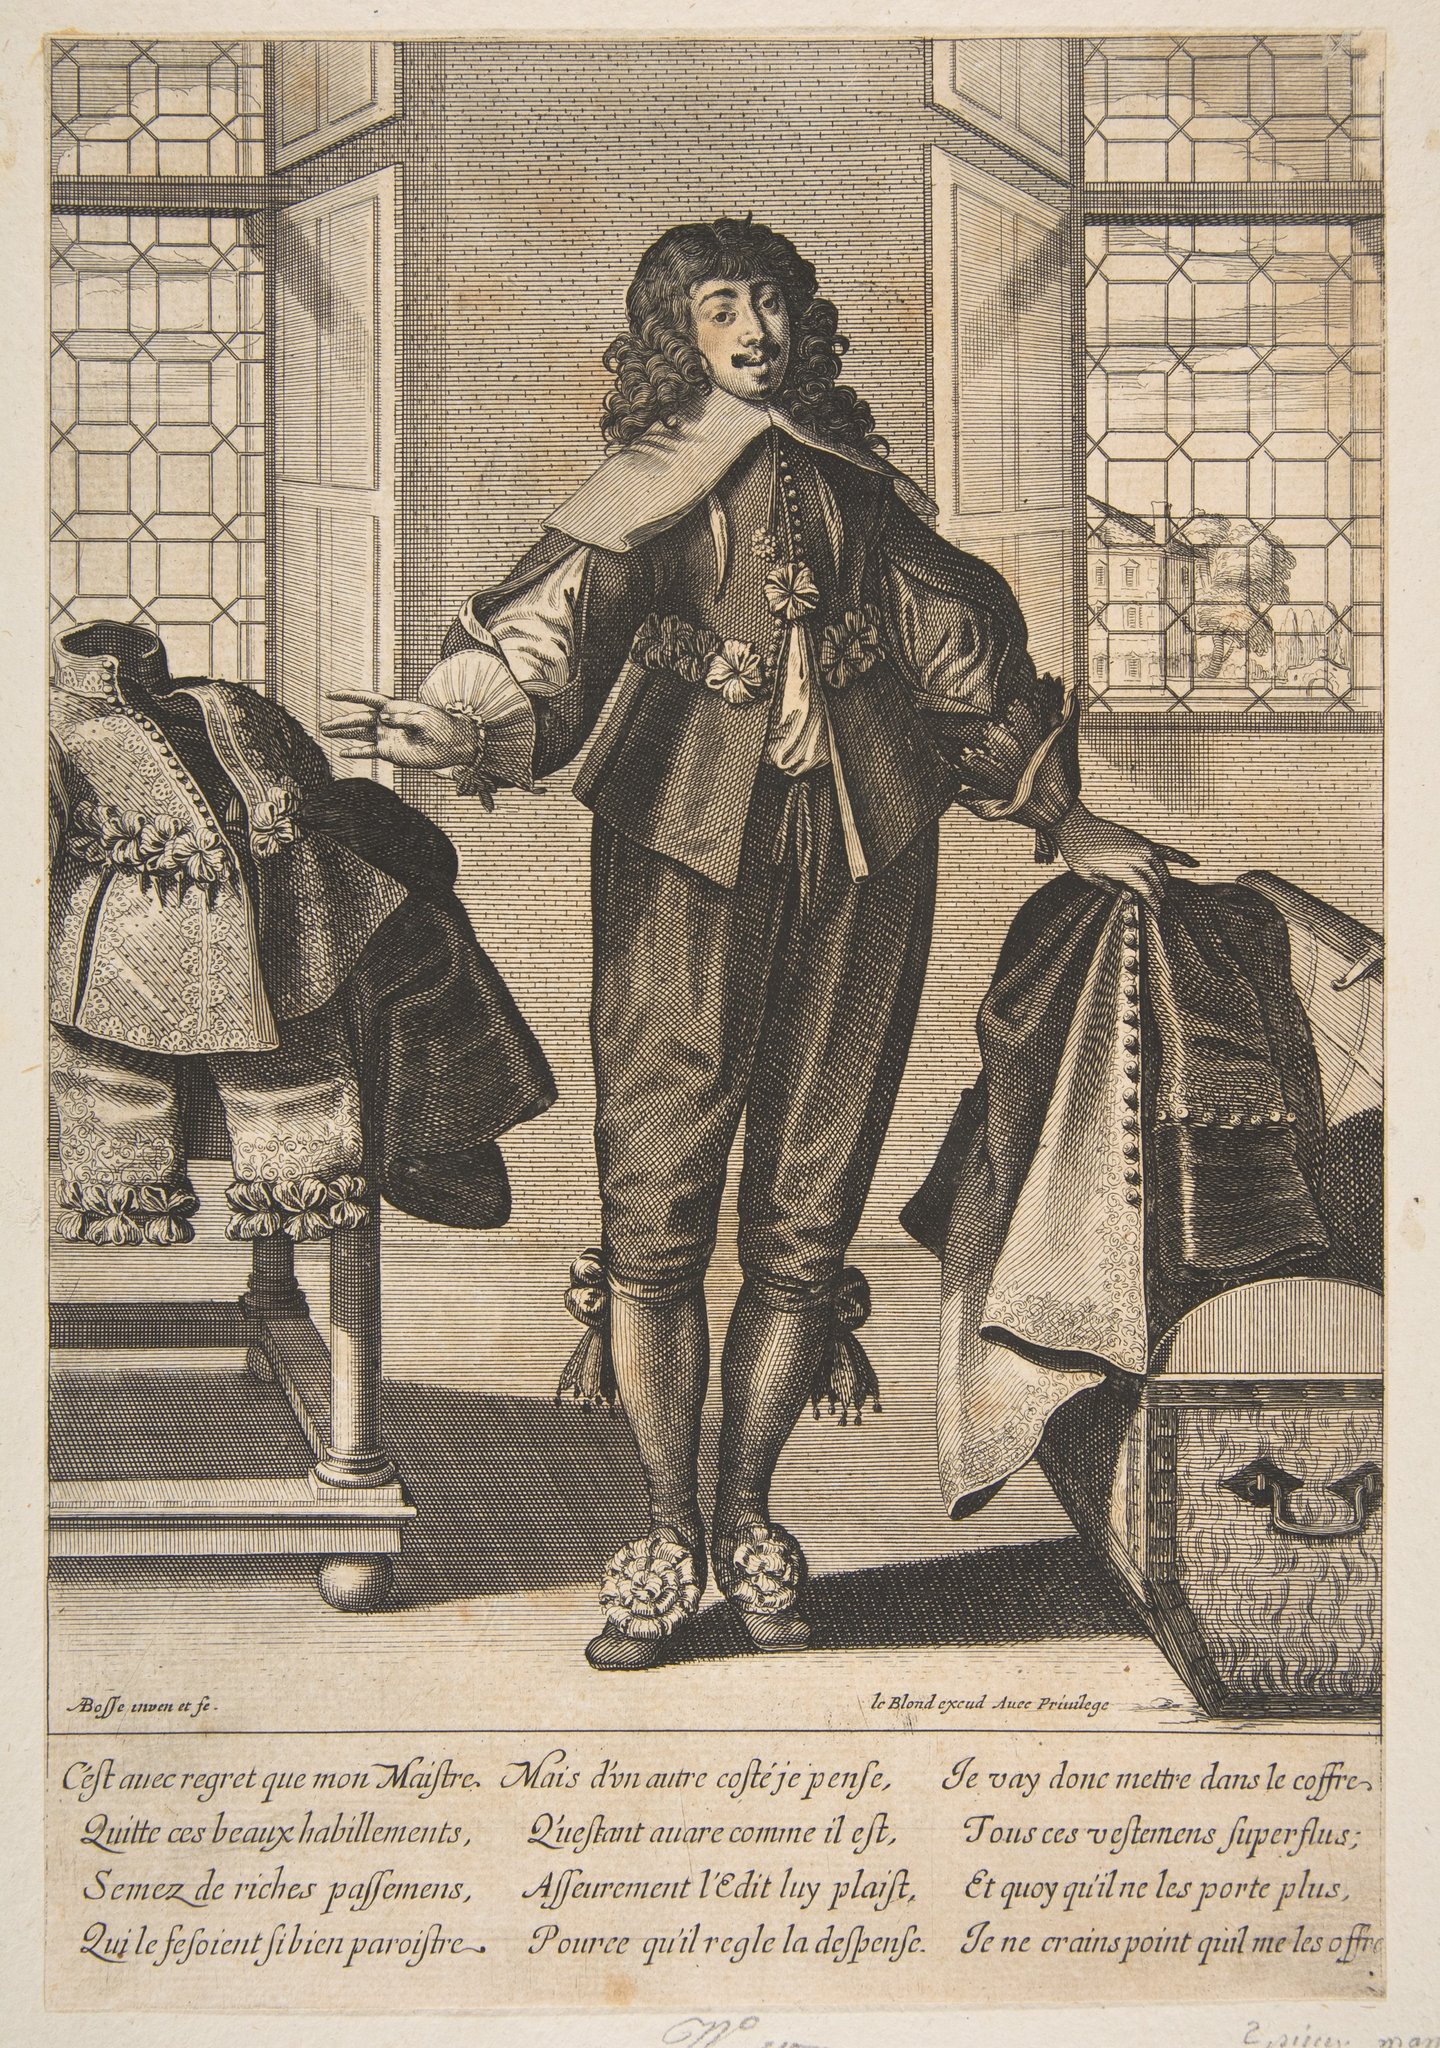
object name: print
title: A Valet Putting Away the Luxurious Clothing of His Master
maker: abraham bosse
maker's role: artist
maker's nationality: french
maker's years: 1602-1676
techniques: etching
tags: men